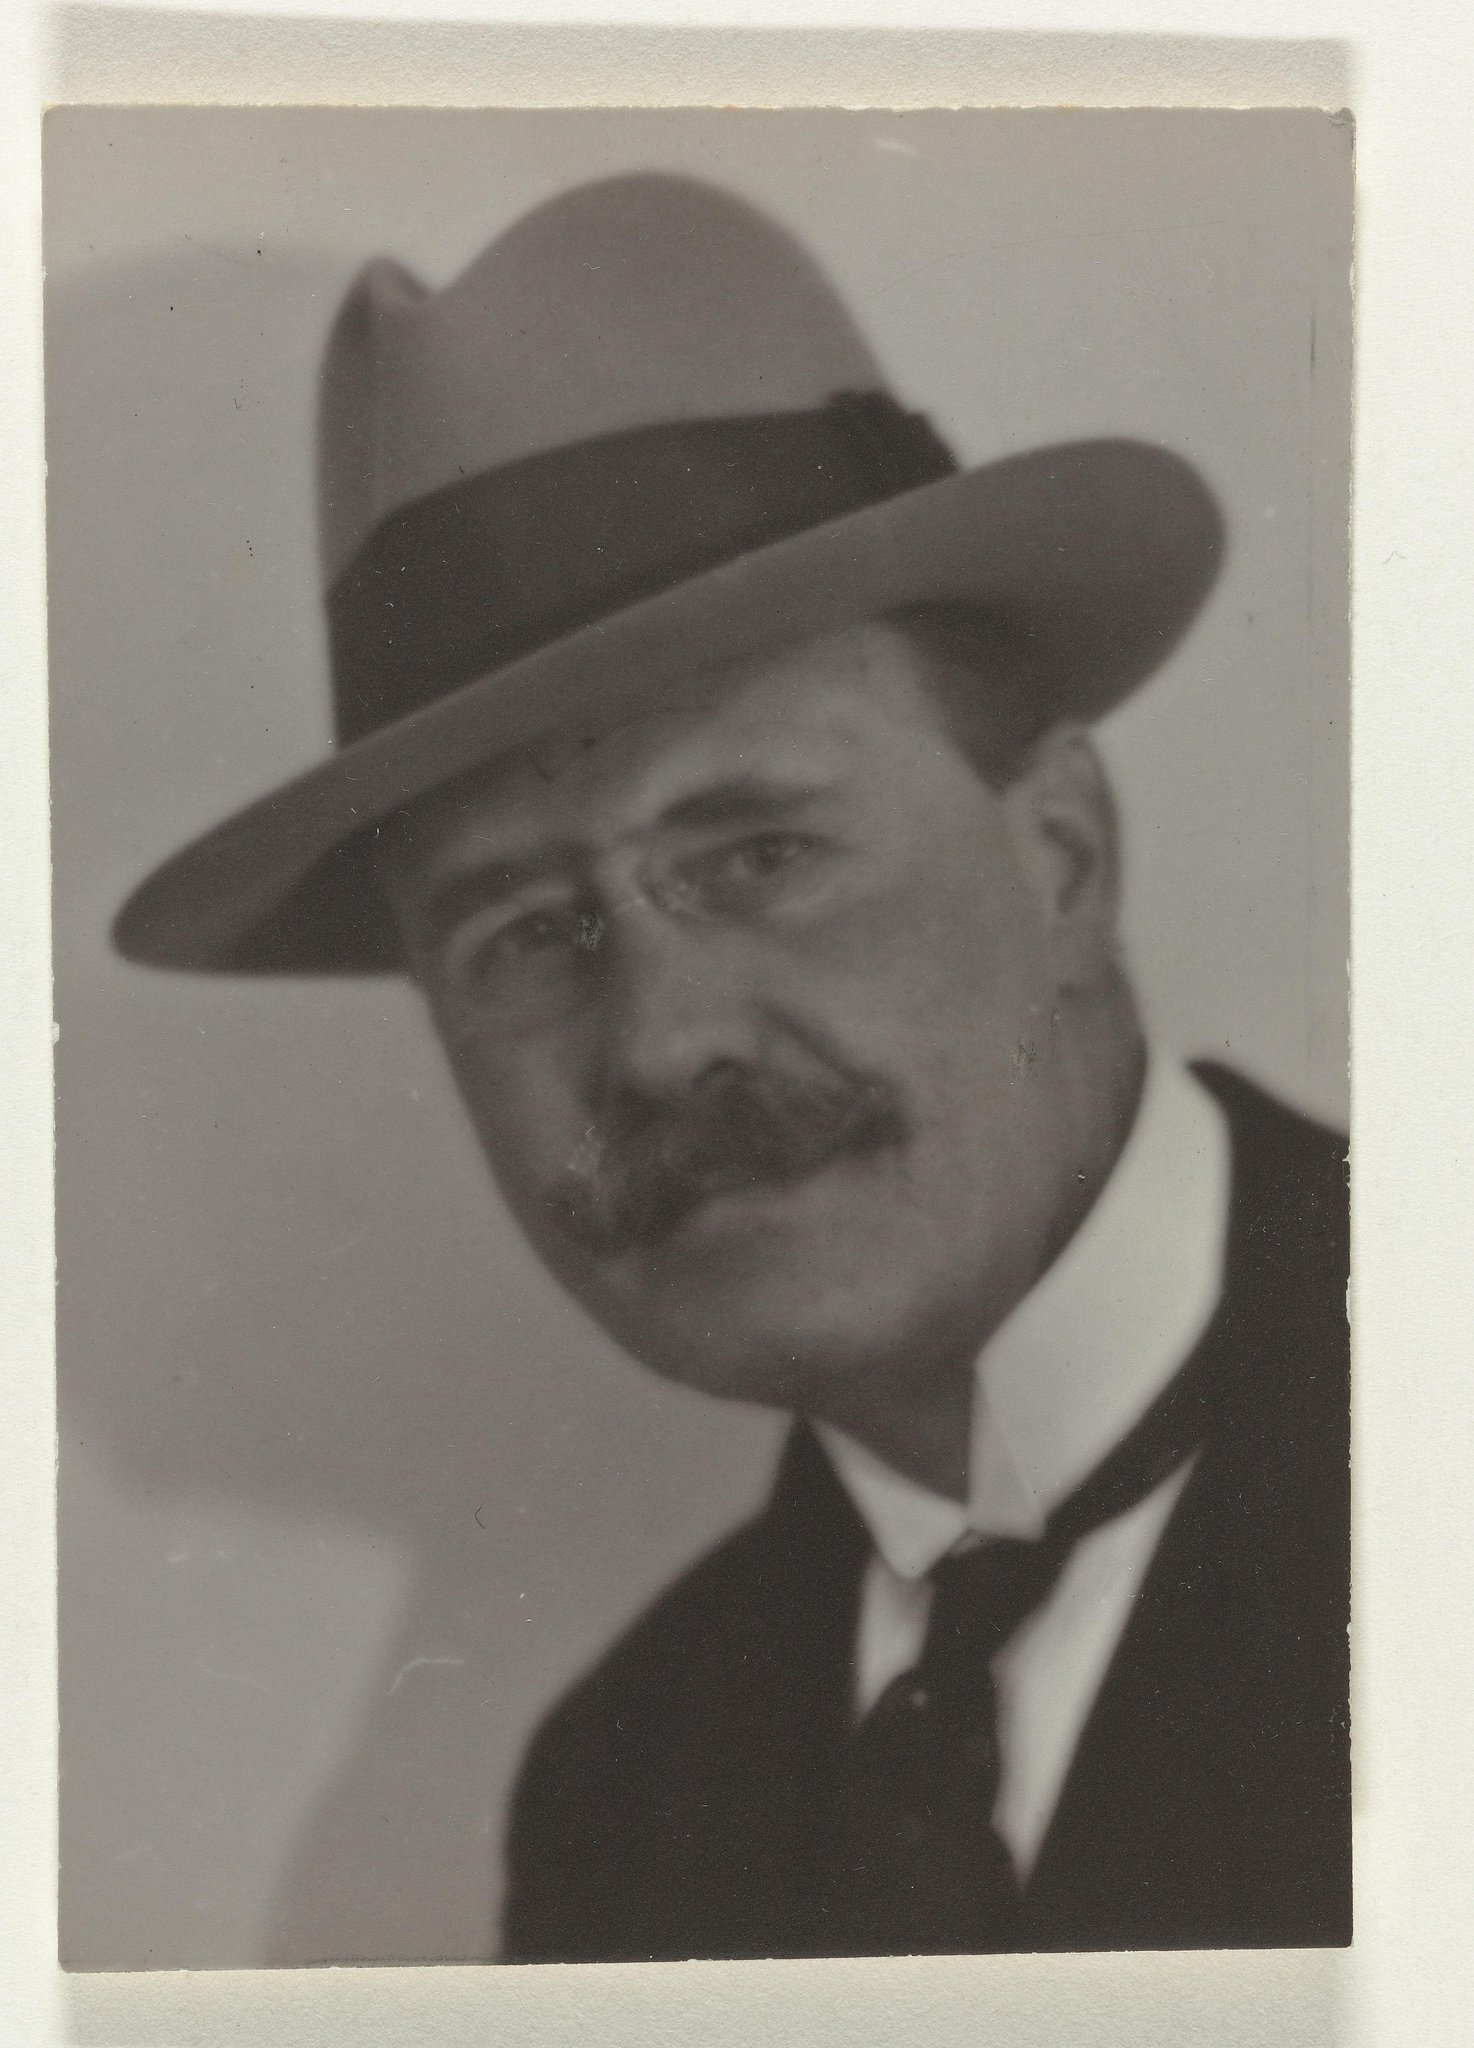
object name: photograph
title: Zelfportret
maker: gerrit elink schuurman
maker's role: fotograaf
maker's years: 1876-1953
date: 1935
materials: photographic support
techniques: gelatin silver print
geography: netherlands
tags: rotterdam, brussels, gerrit elink schuurman, portrait, self-portrait of photographer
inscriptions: annotation: ‘Gerrit Elink Schuurman // geboren Rotterdam 1876 // gestorven Brussel 1953’